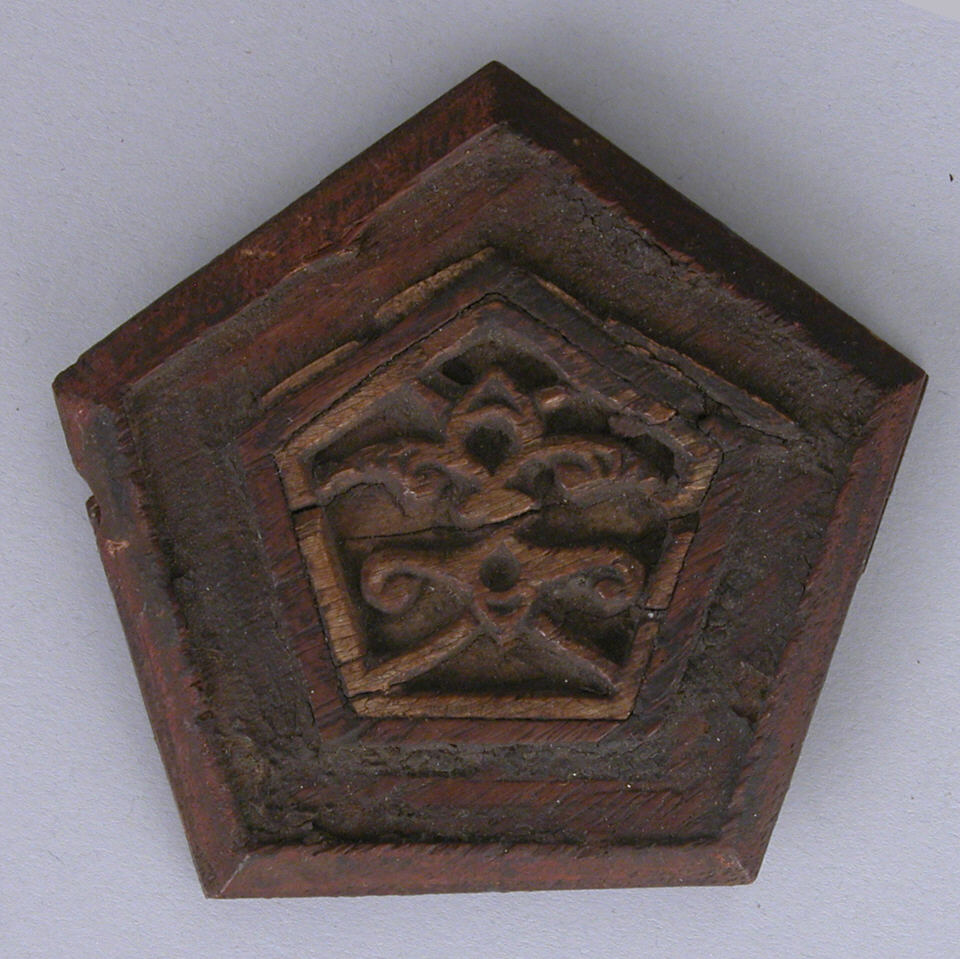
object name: panel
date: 1301-1500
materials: wood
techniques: carving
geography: egypt